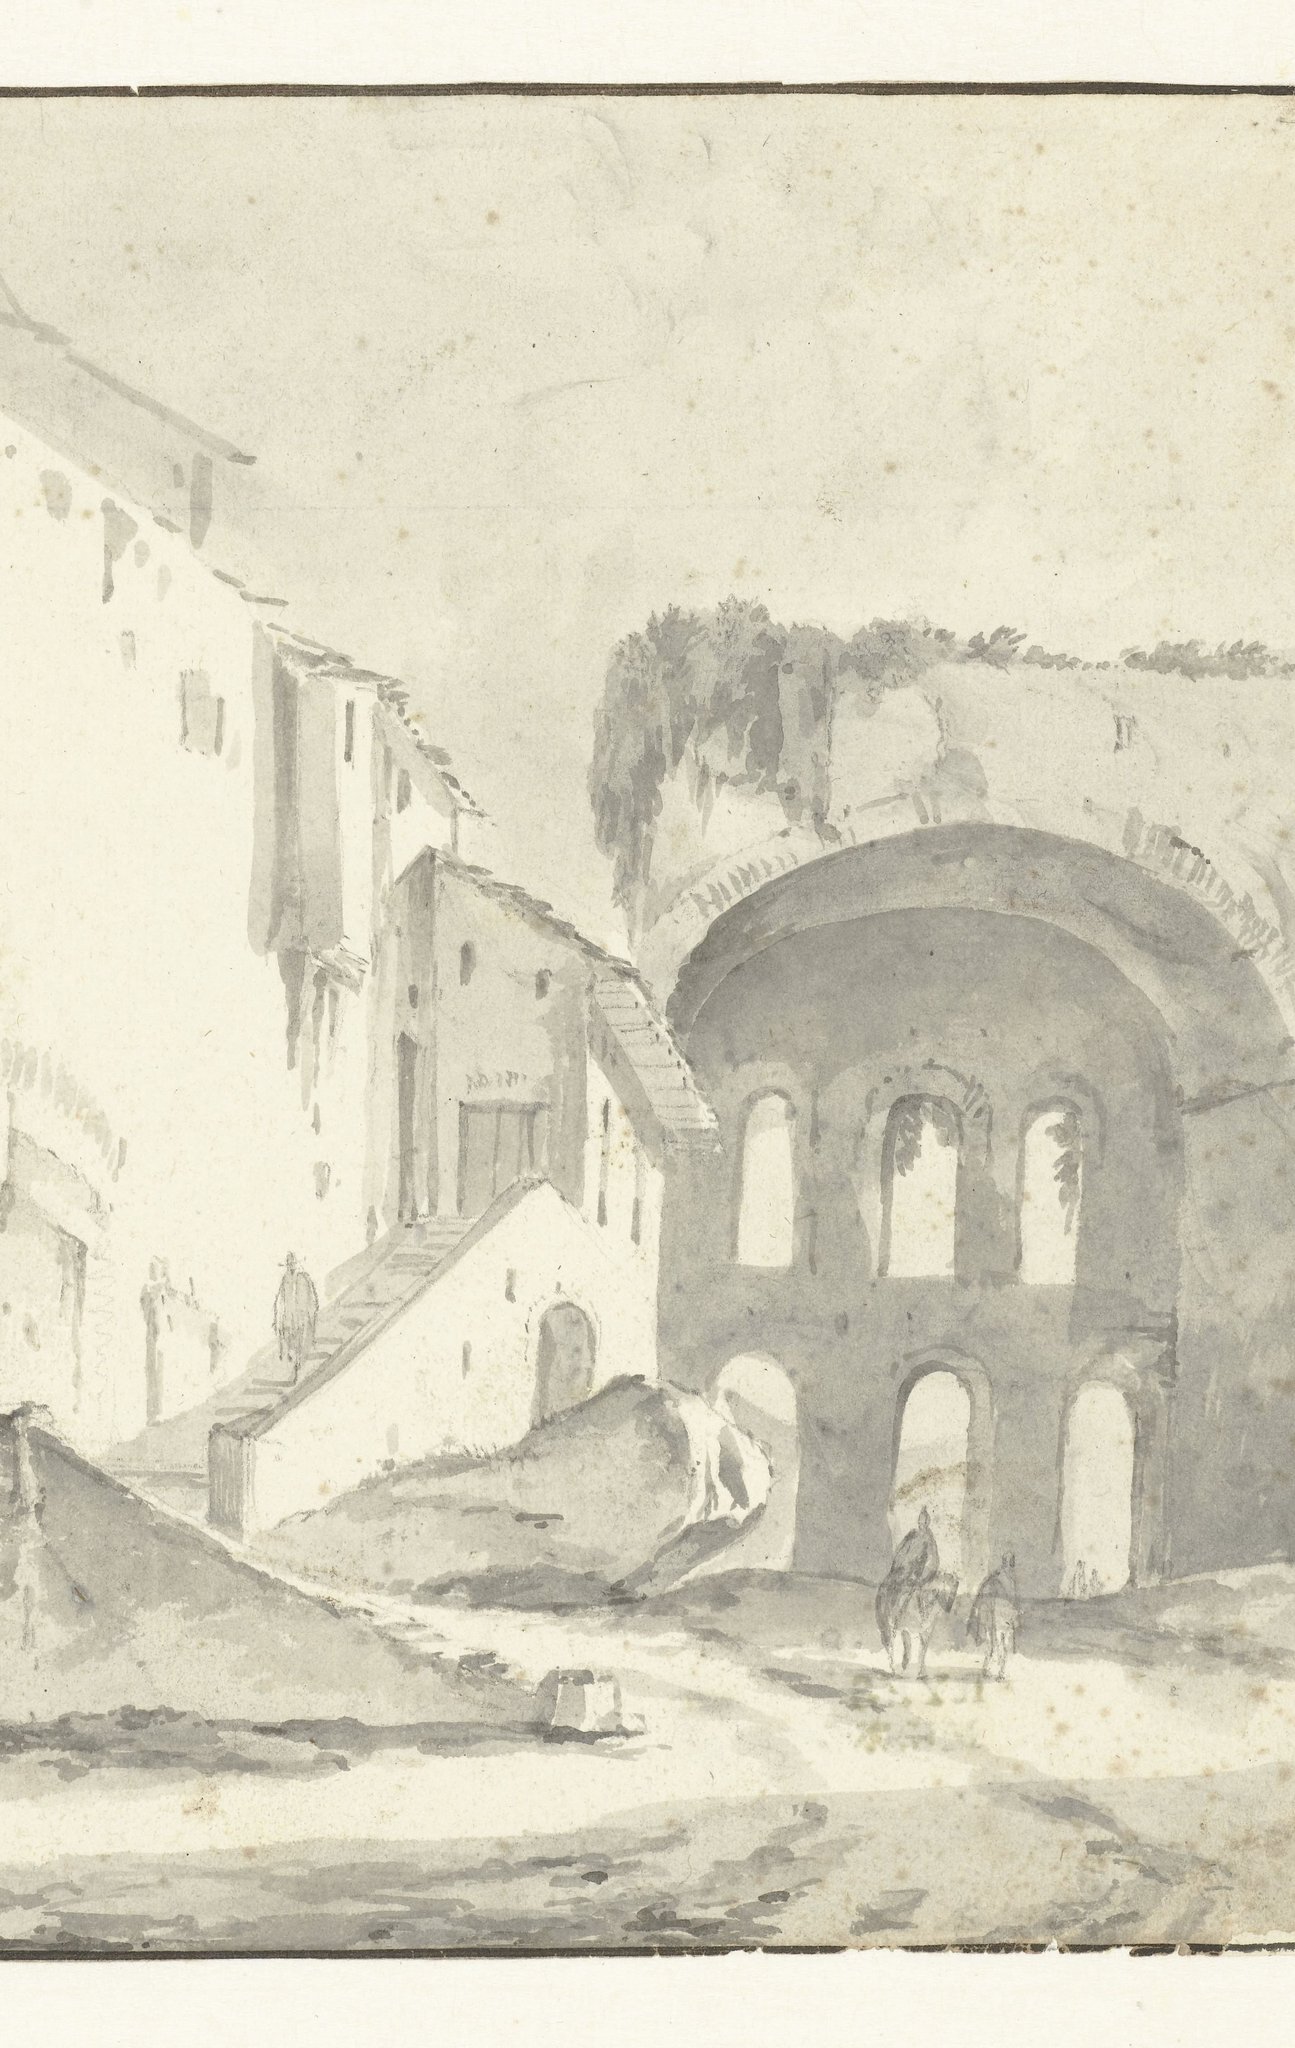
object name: drawing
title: Gezicht op de ruïne van de basiliek van Constantijn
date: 1610-1657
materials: paper, pencil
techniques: brush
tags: basilica van maxentius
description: Links huizen met daartegen een stenen trap, rechts de begroeide ruïne van de absis van de basiliek van Constantijn, ervoor een ruiter en voetgangers.